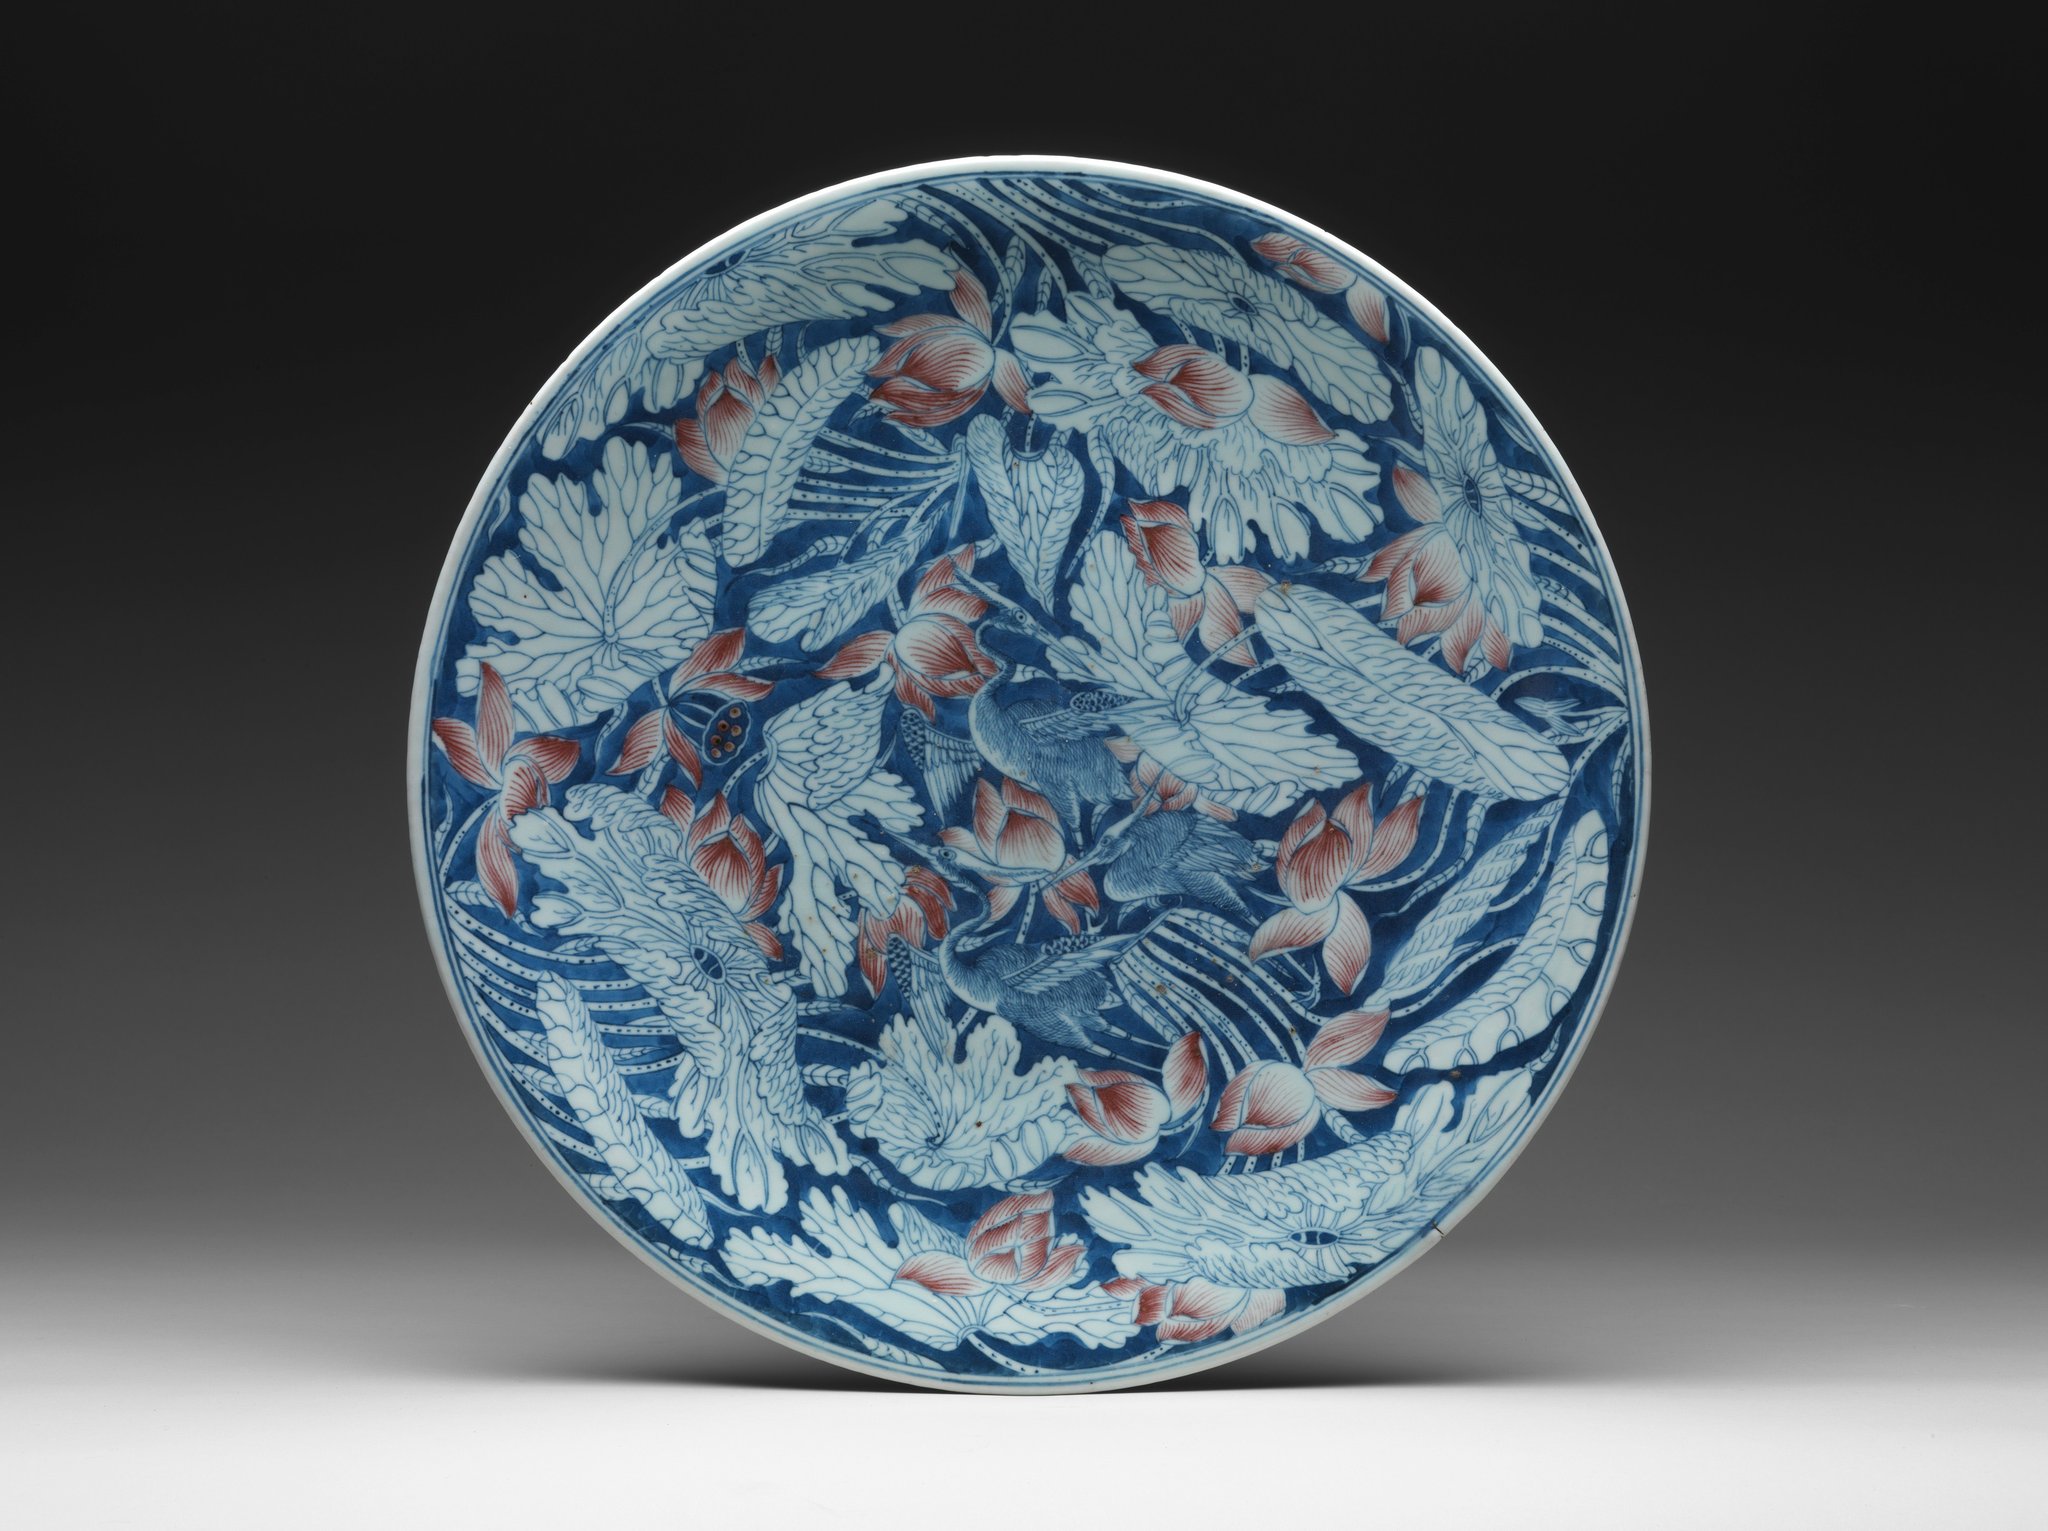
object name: plate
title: Plate with egrets in a lotus pond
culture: chinese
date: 1867-1900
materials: cobalt, copper, porcelain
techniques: painting, underglaze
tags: birds,lotuses,leaves